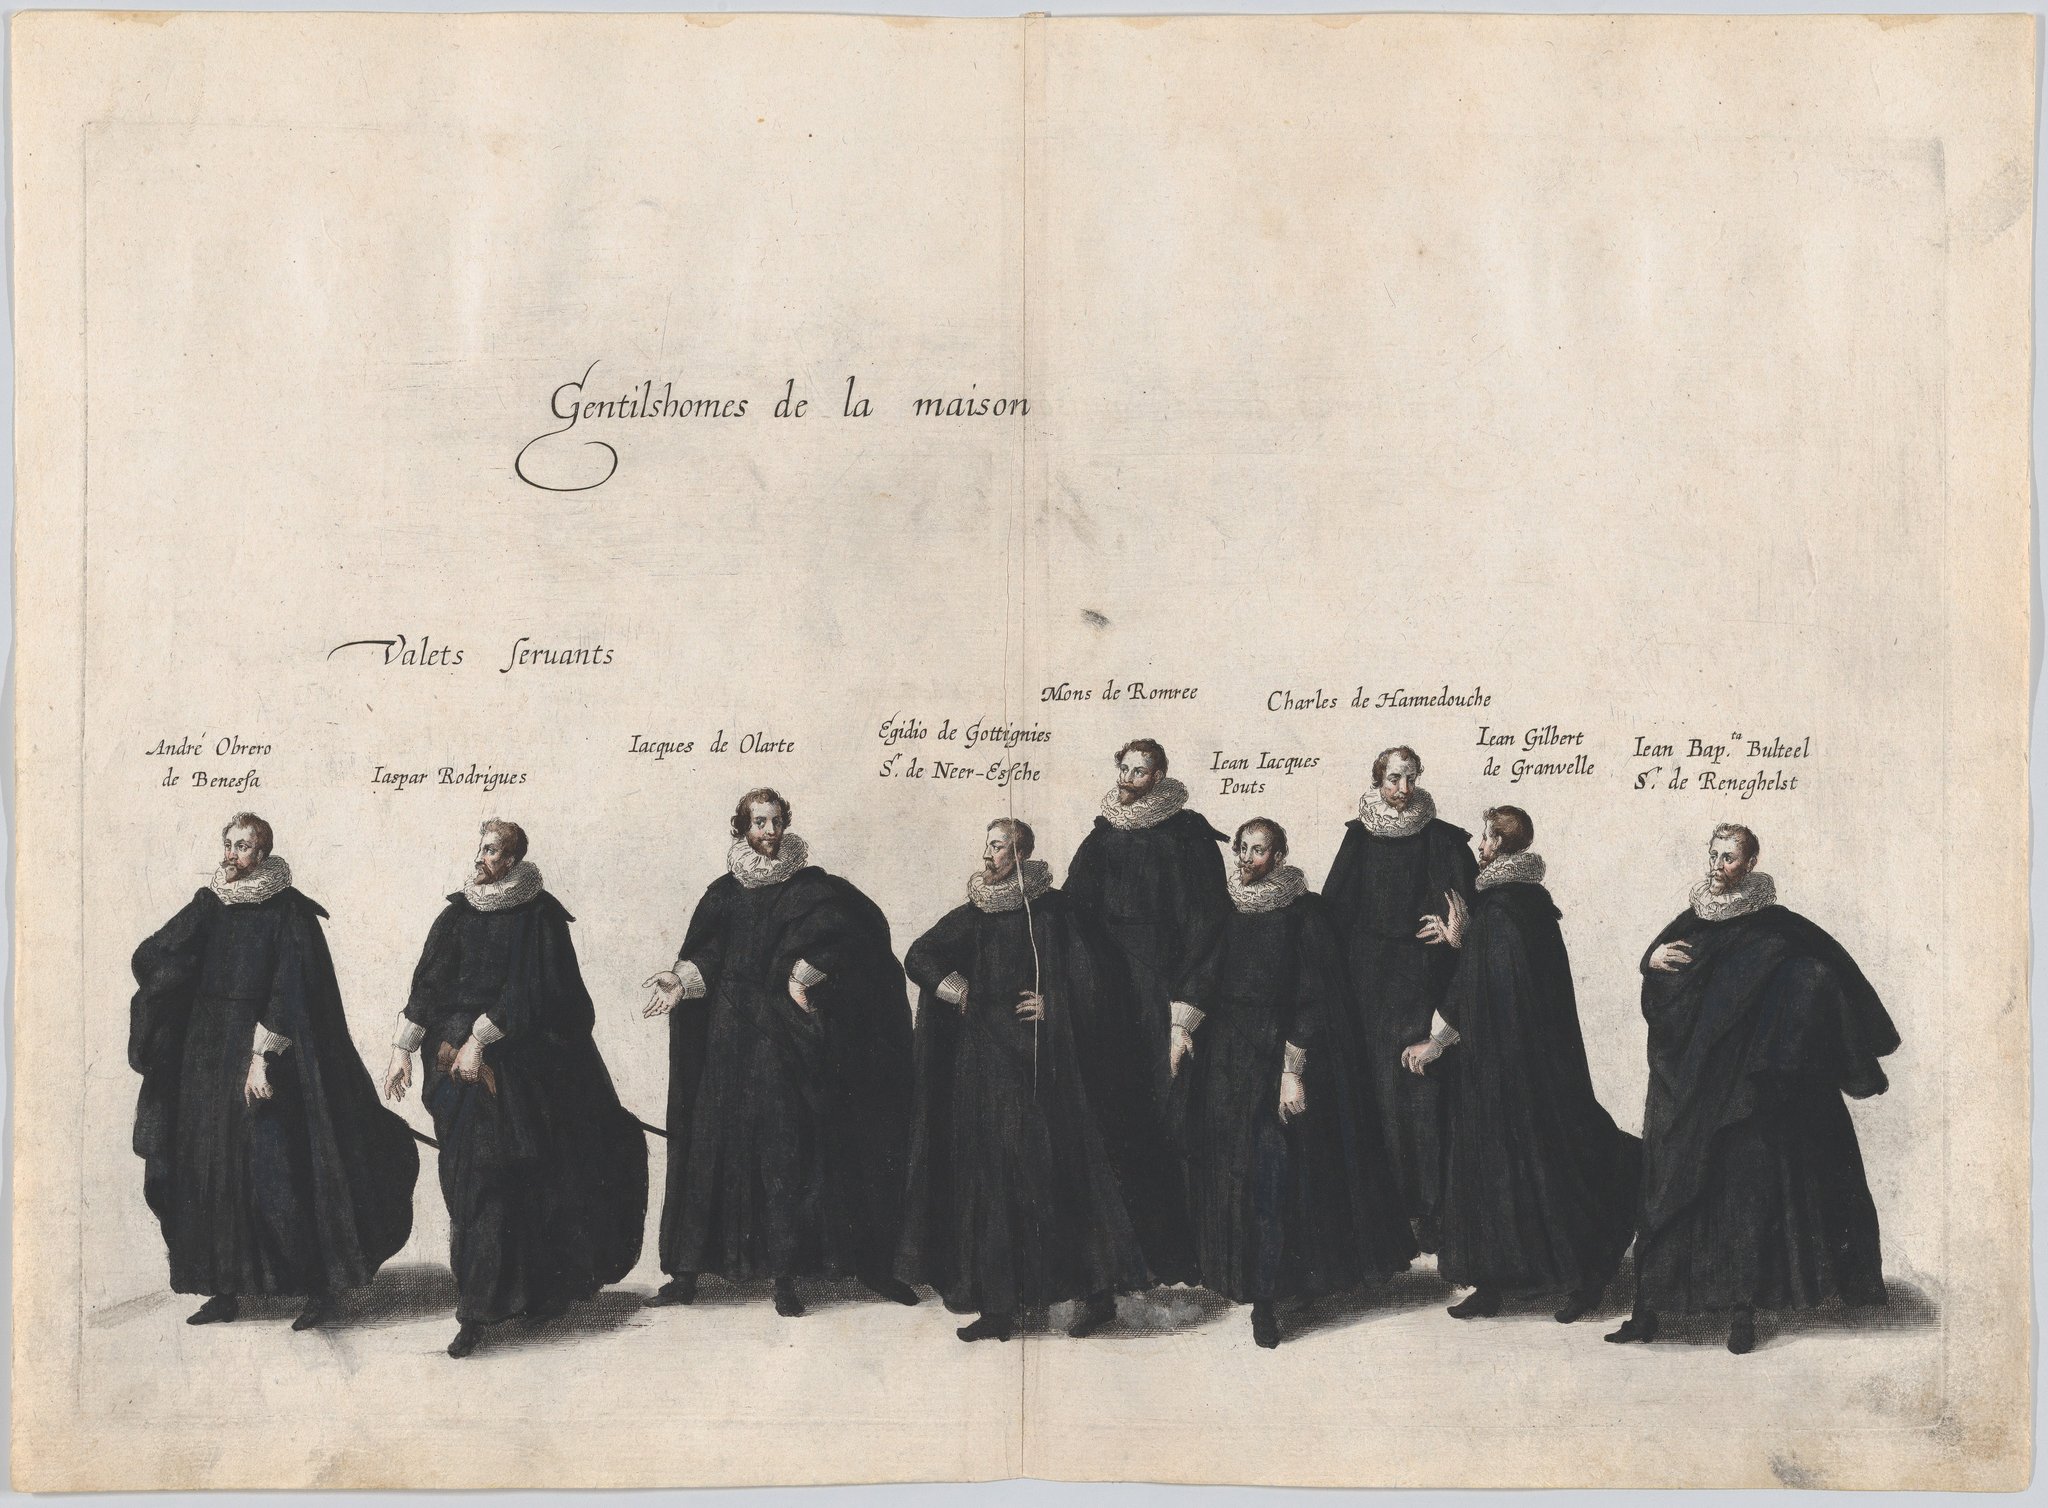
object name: print, fete, ornament architecture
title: Plate 23: Gentlemen of the house marching in the funeral procession of Archduke Albert of Austria; from 'Pompa Funebris ... Alberti Pii'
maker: cornelis galle (i)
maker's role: artist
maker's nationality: netherlandish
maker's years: 1576-1650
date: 1623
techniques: etching, hand coloring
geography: brussels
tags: men,funerals